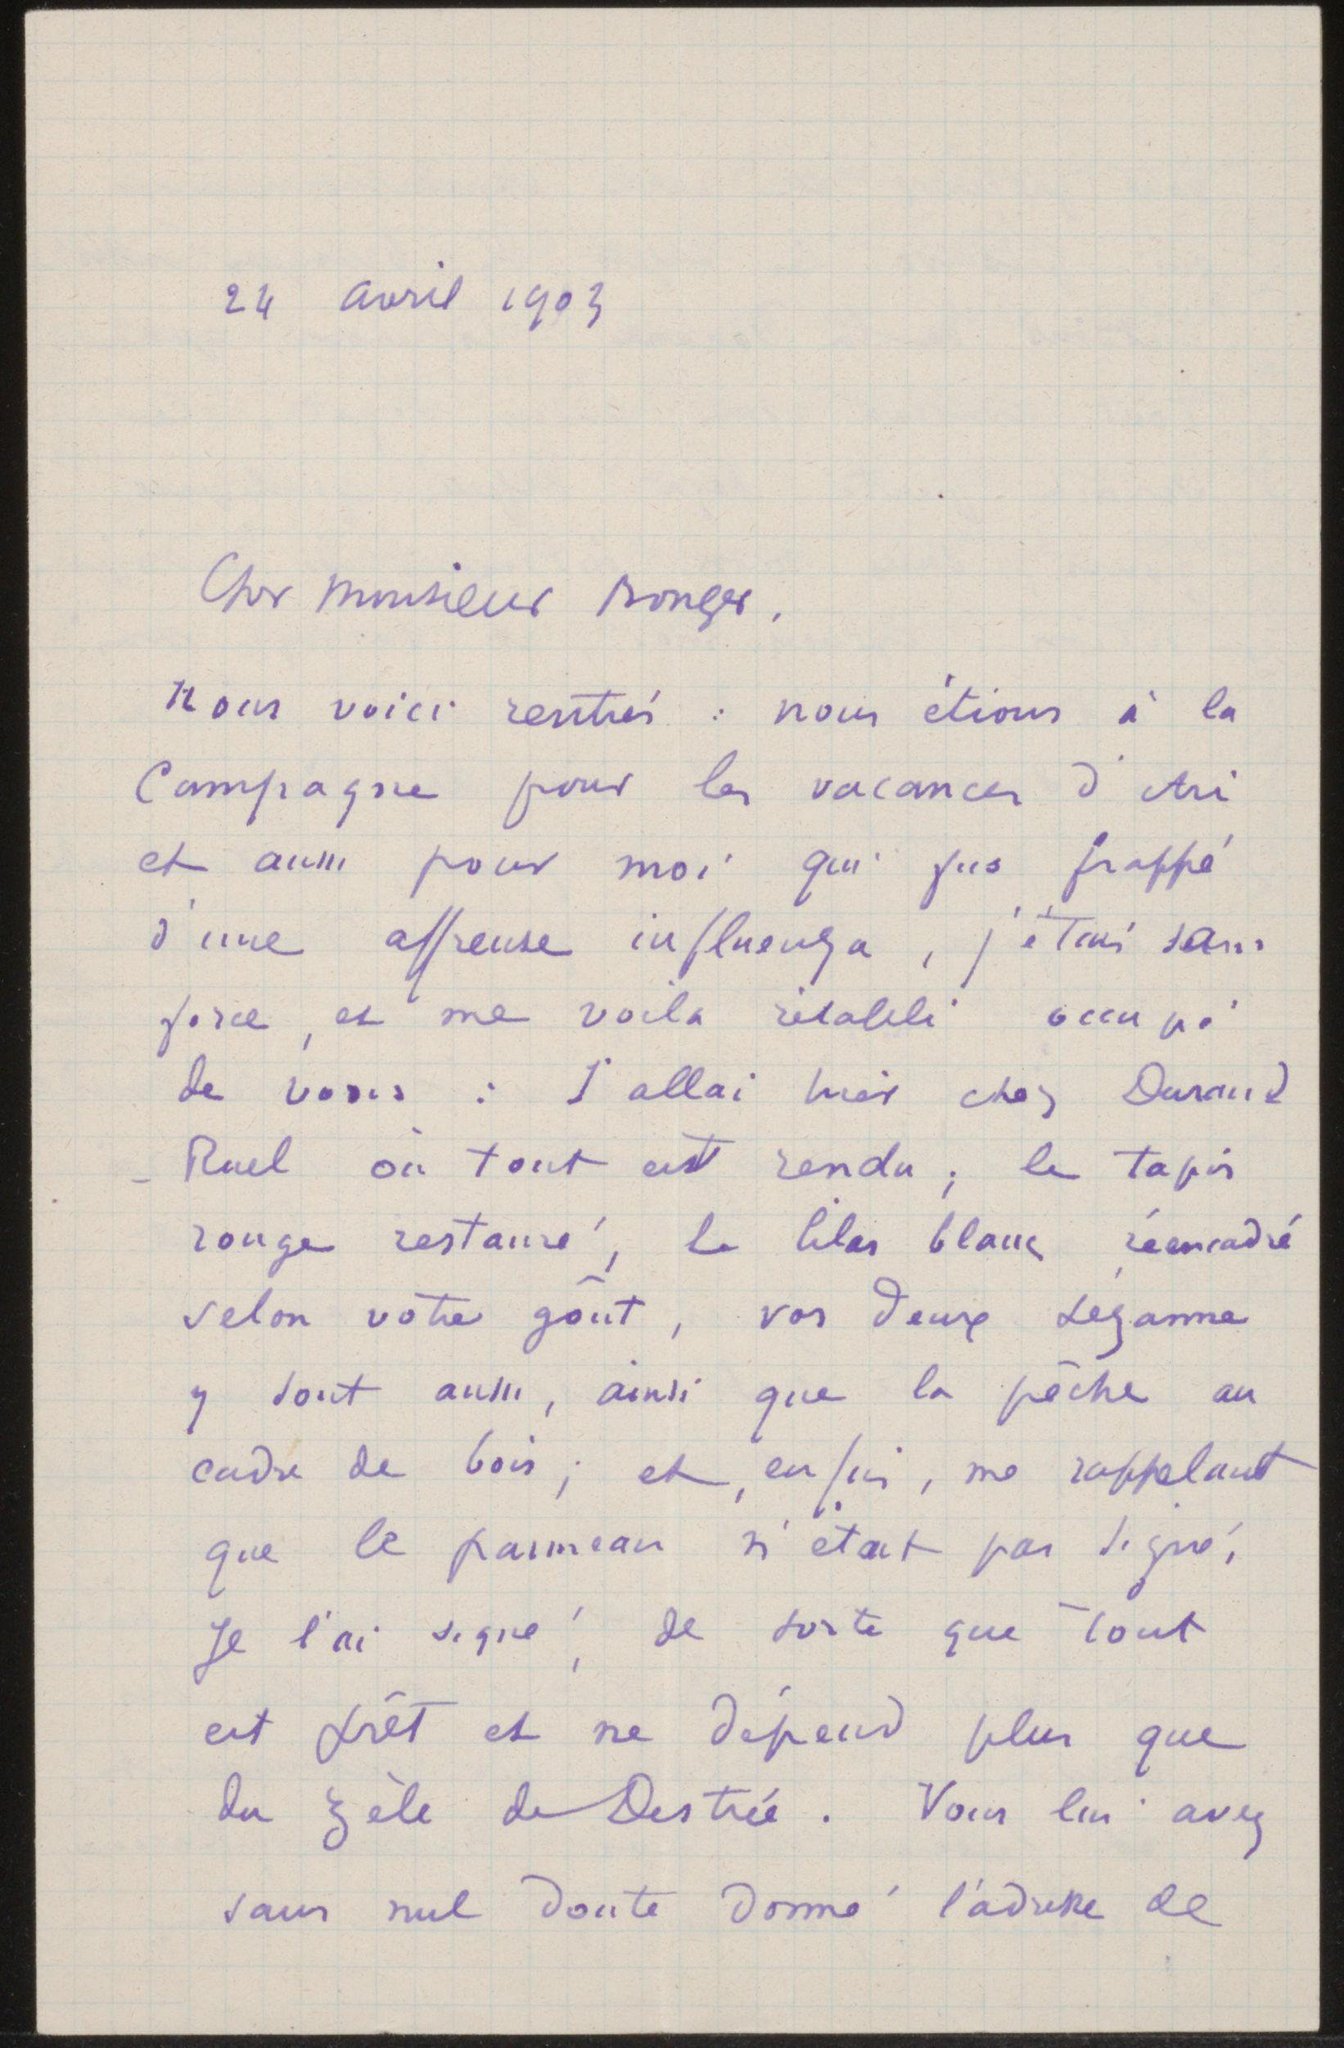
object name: letter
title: Brief aan Andries Bonger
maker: odilon redon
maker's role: draughtsman, painter, print maker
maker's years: 1840-1916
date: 1903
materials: ink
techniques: pen, writing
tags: arï redon, lille, émile bernard, pierre bonnard, amsterdam, andries bonger, nicolas boileau, france, jean racine, brussels, politician, jules destrée, applied arts, arts and crafts; industrial design, the graphic arts, exhibition ~ art, money, paris, venice